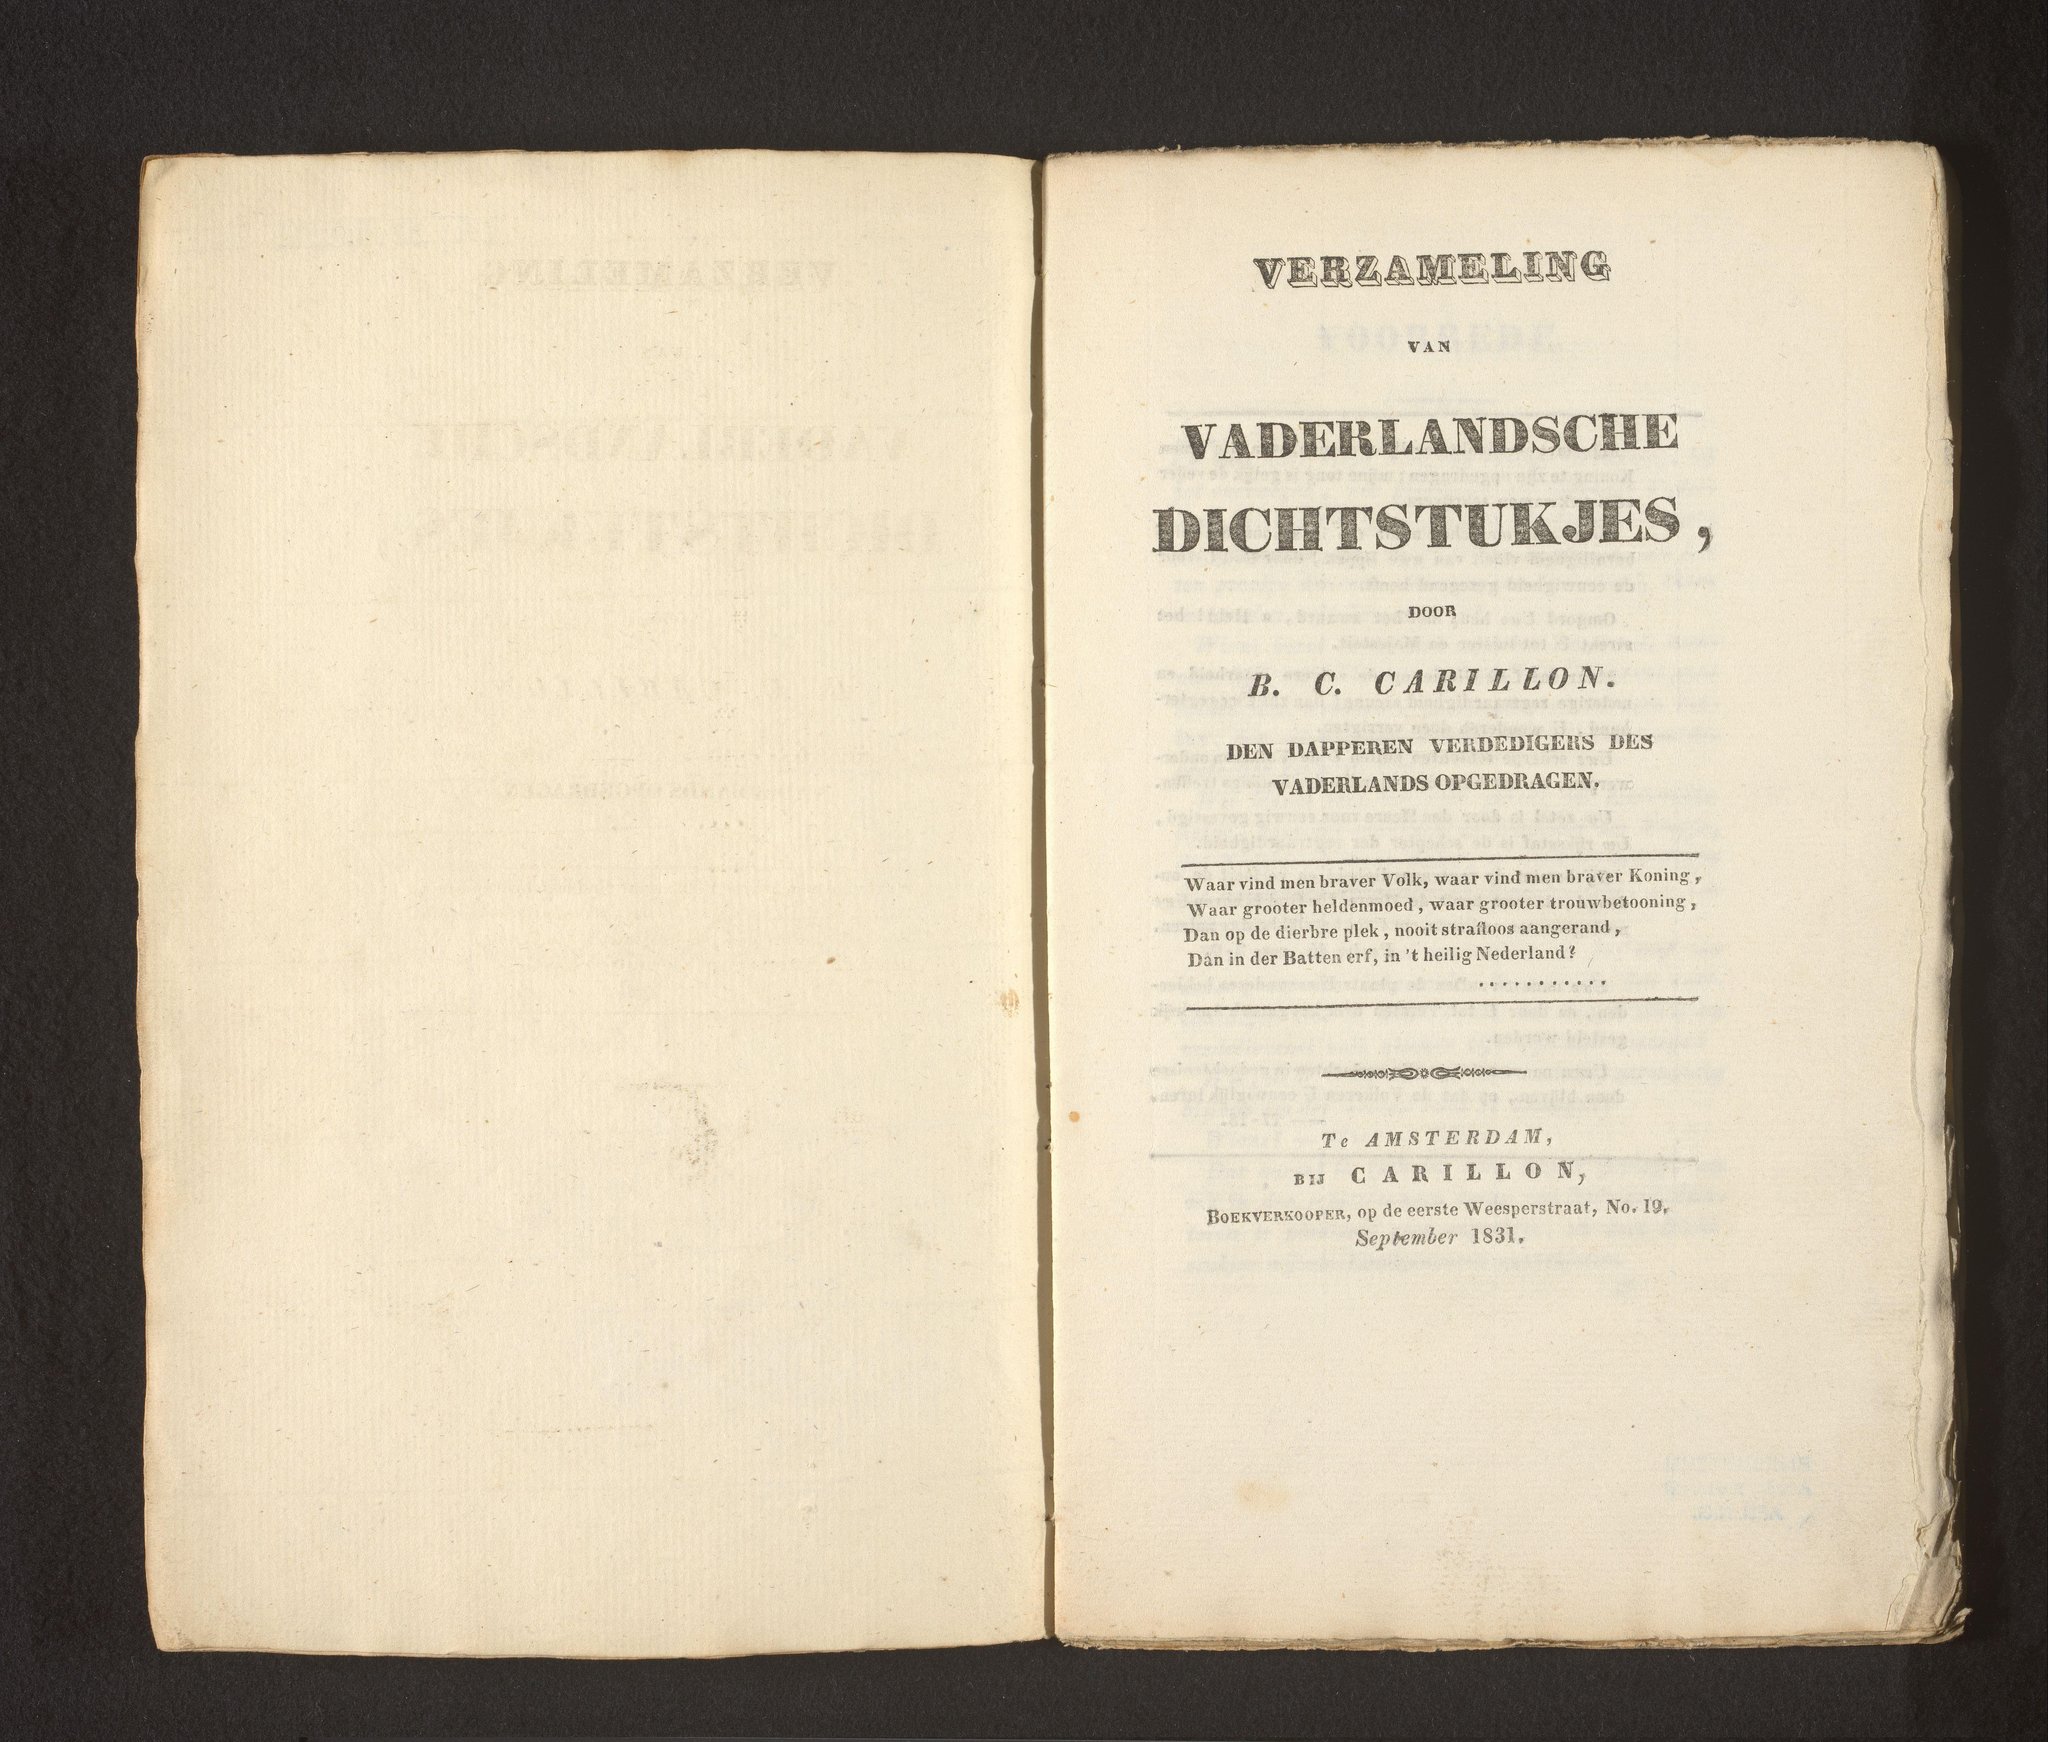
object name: brochure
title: Verzameling van Vaderlandsche Dichtstukjes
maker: benjamin cohen carillon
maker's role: schrijver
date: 1809-1831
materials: paper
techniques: printing, sewing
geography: amsterdam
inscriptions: date